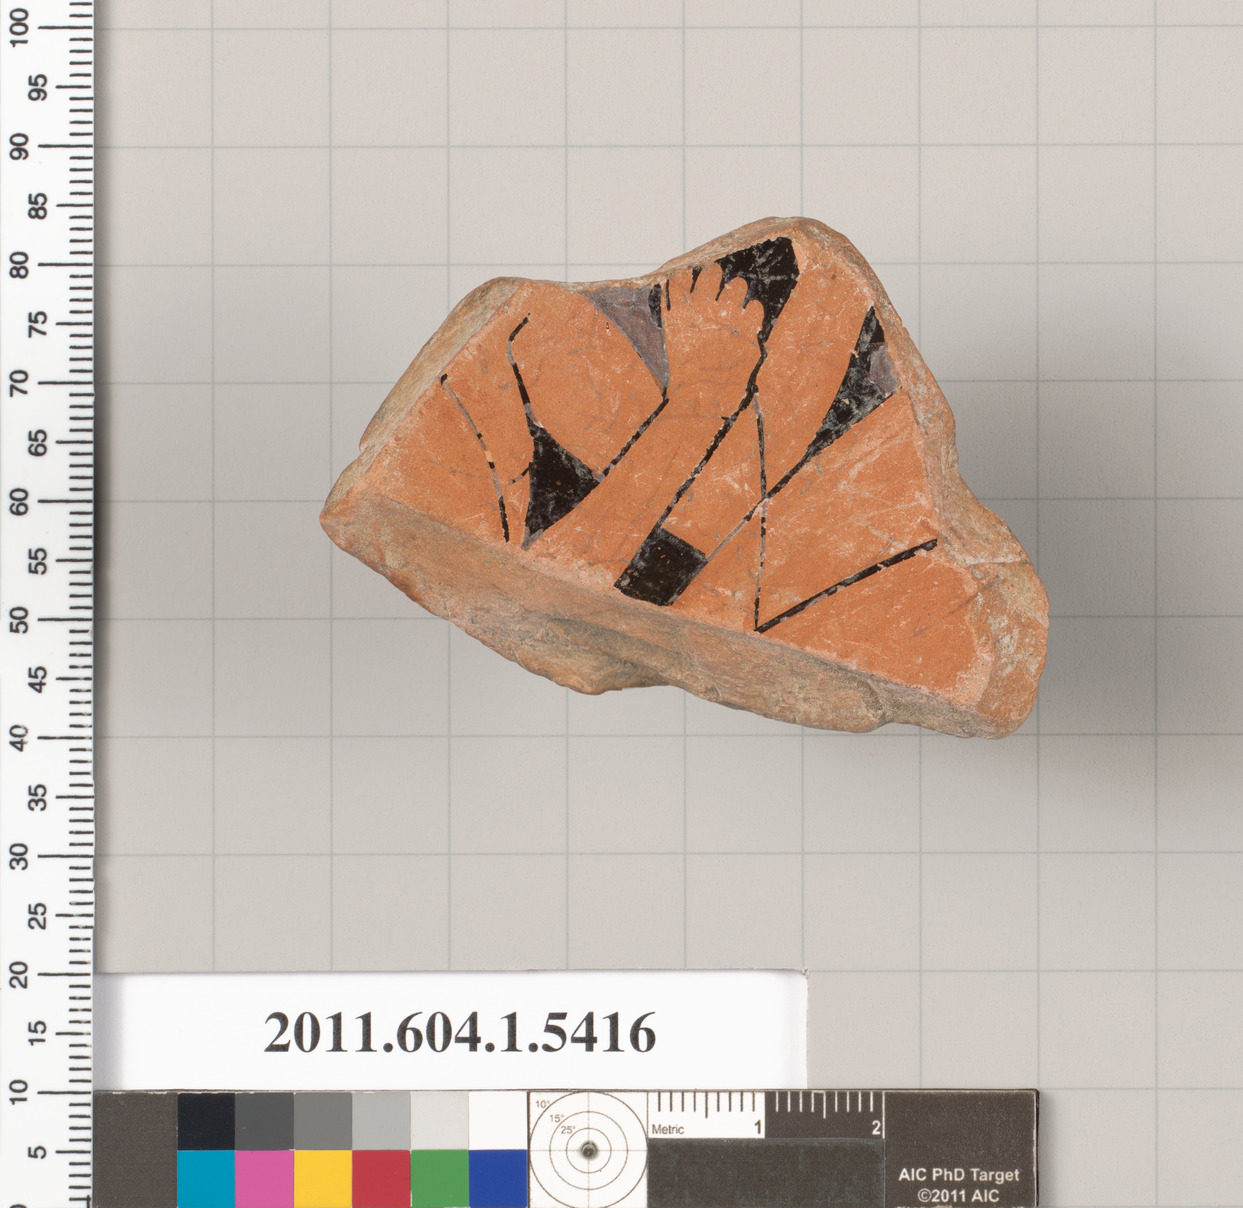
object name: kylix fragment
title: Terracotta fragment of a kylix (drinking cup)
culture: greek, attic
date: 500-480 BCE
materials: terracotta